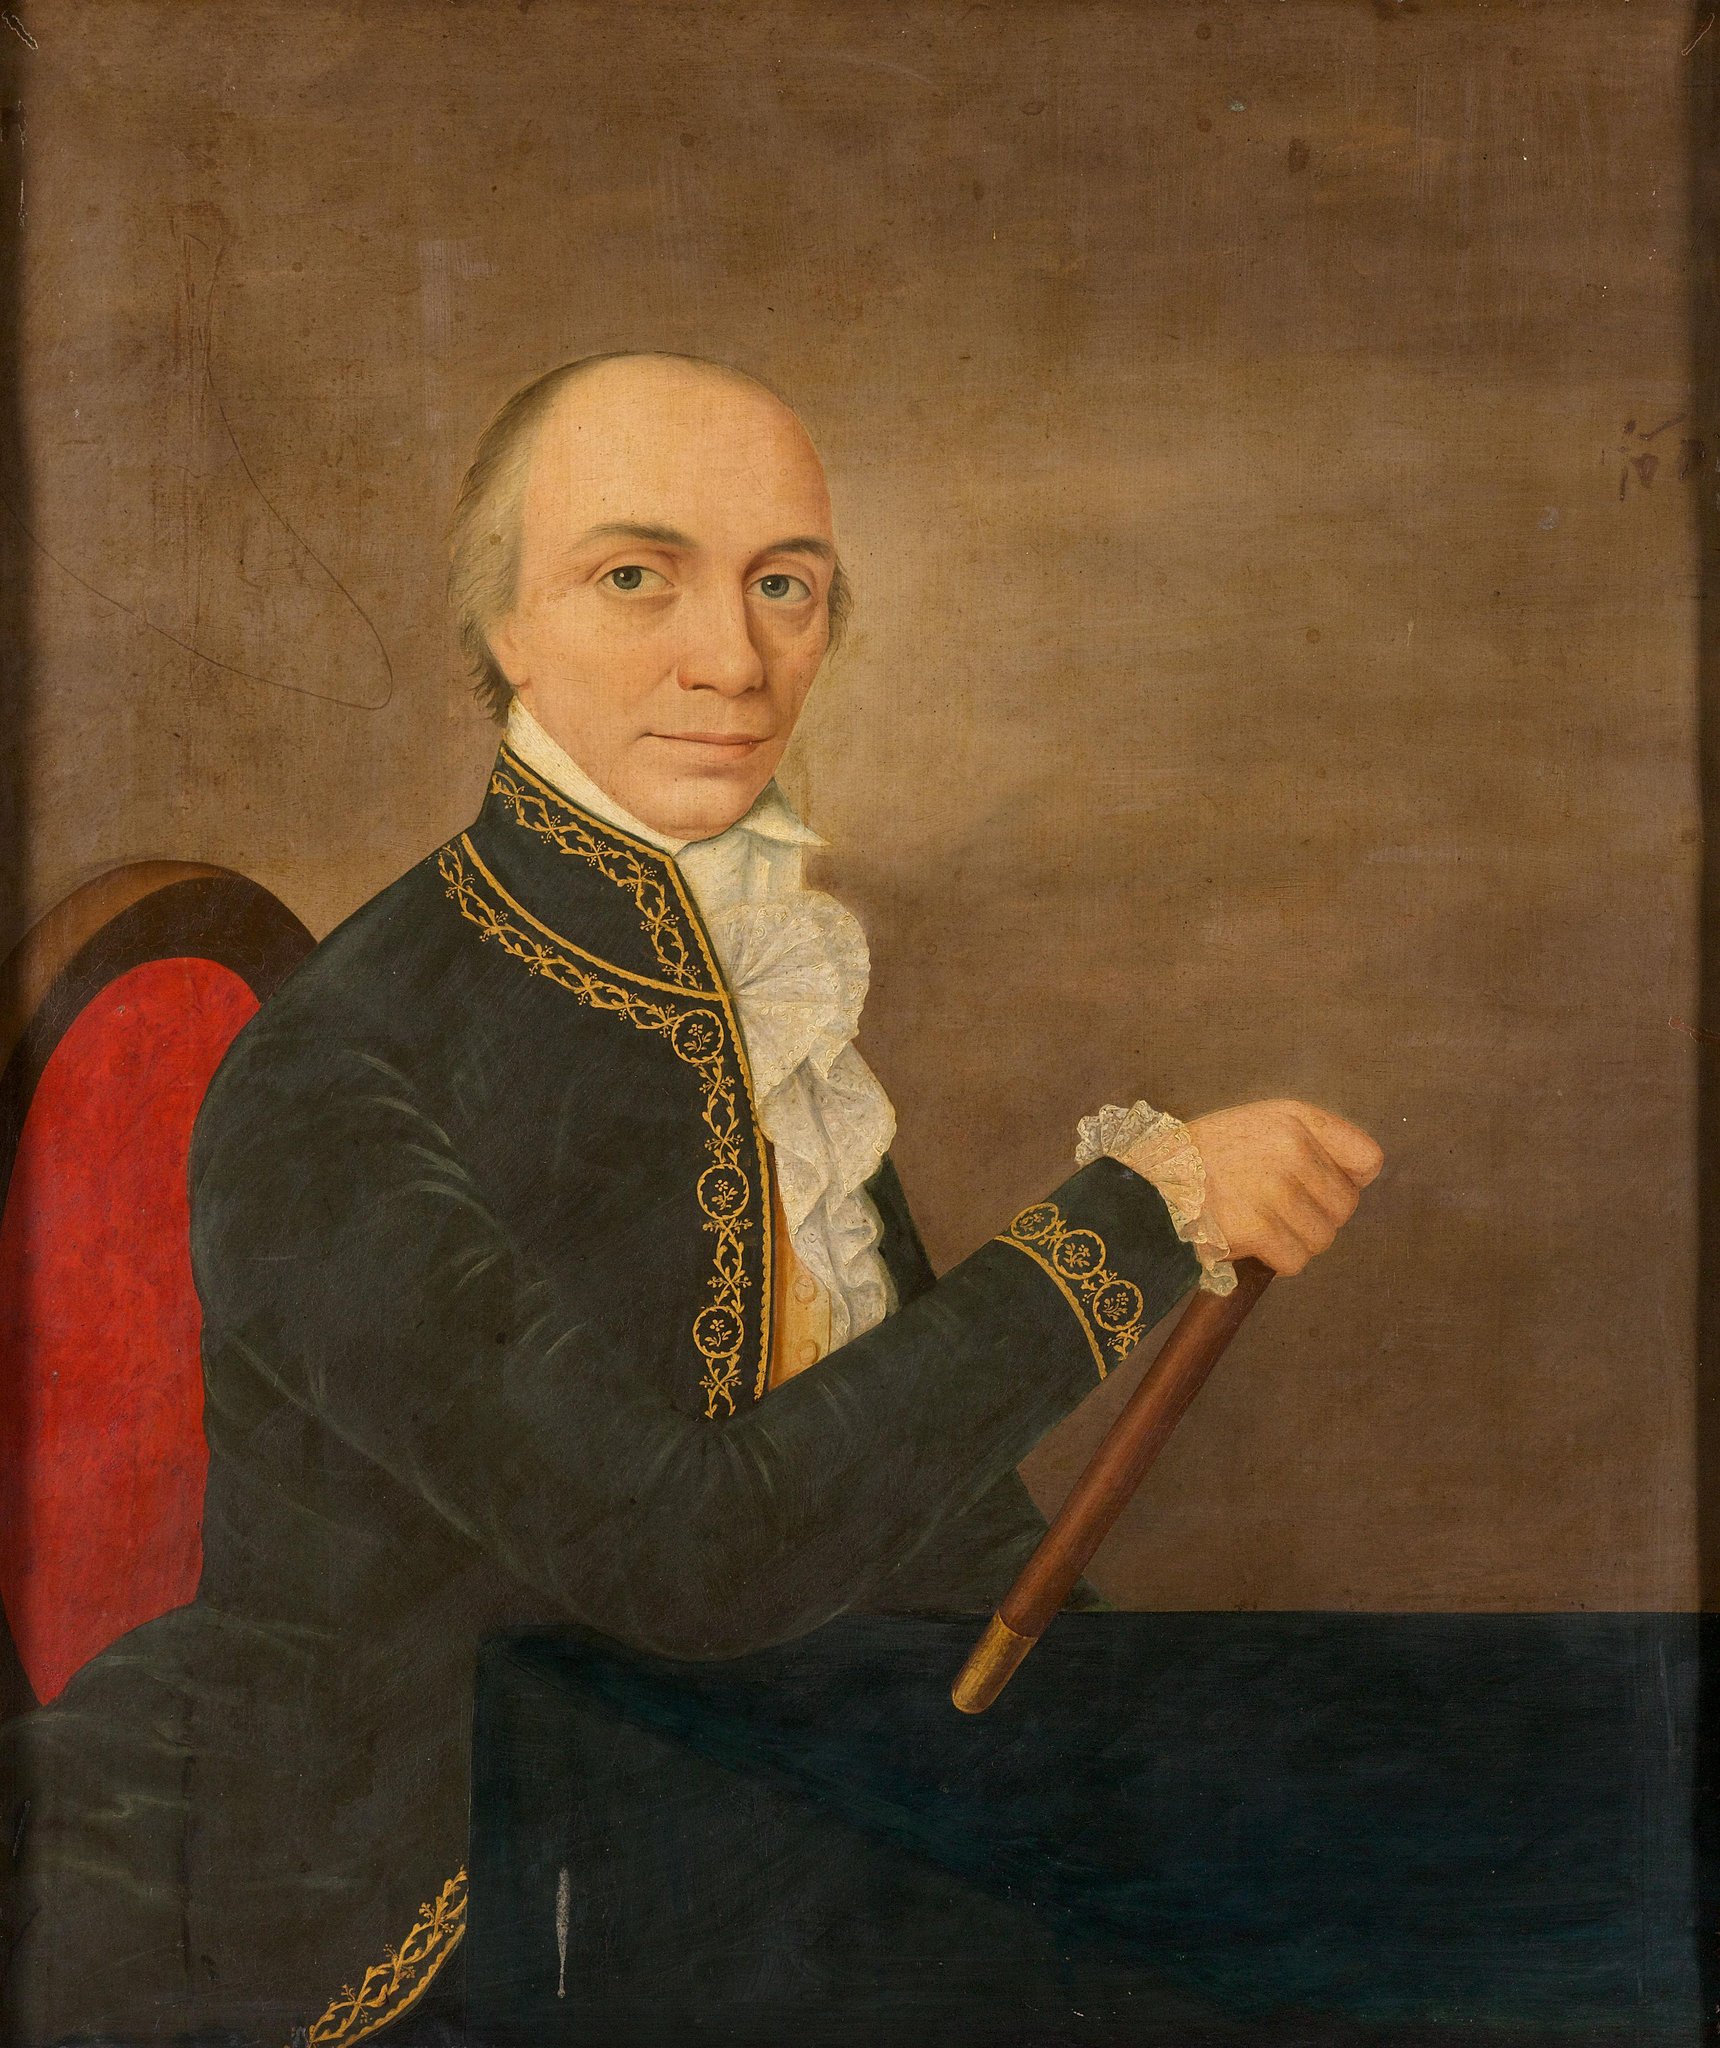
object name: painting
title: Portrait of Johannes Siberg, Governor-General of the Dutch East Indies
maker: Anonymous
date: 1800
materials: copper, oil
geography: netherlands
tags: colonial governor, historical persons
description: Portret van Johannes Siberg (1740-1817). Gouverneur-generaal (1801-05). Ten halven lijve, zittend in een stoel aan een tafel, naar links, het gelaat naar de beschouwer gekeerd. In de rechterhand een commandostaf. Onderdeel van een reeks van portretten van de gouverneurs-generaal van het voormalige Nederlands Oost-Indië.